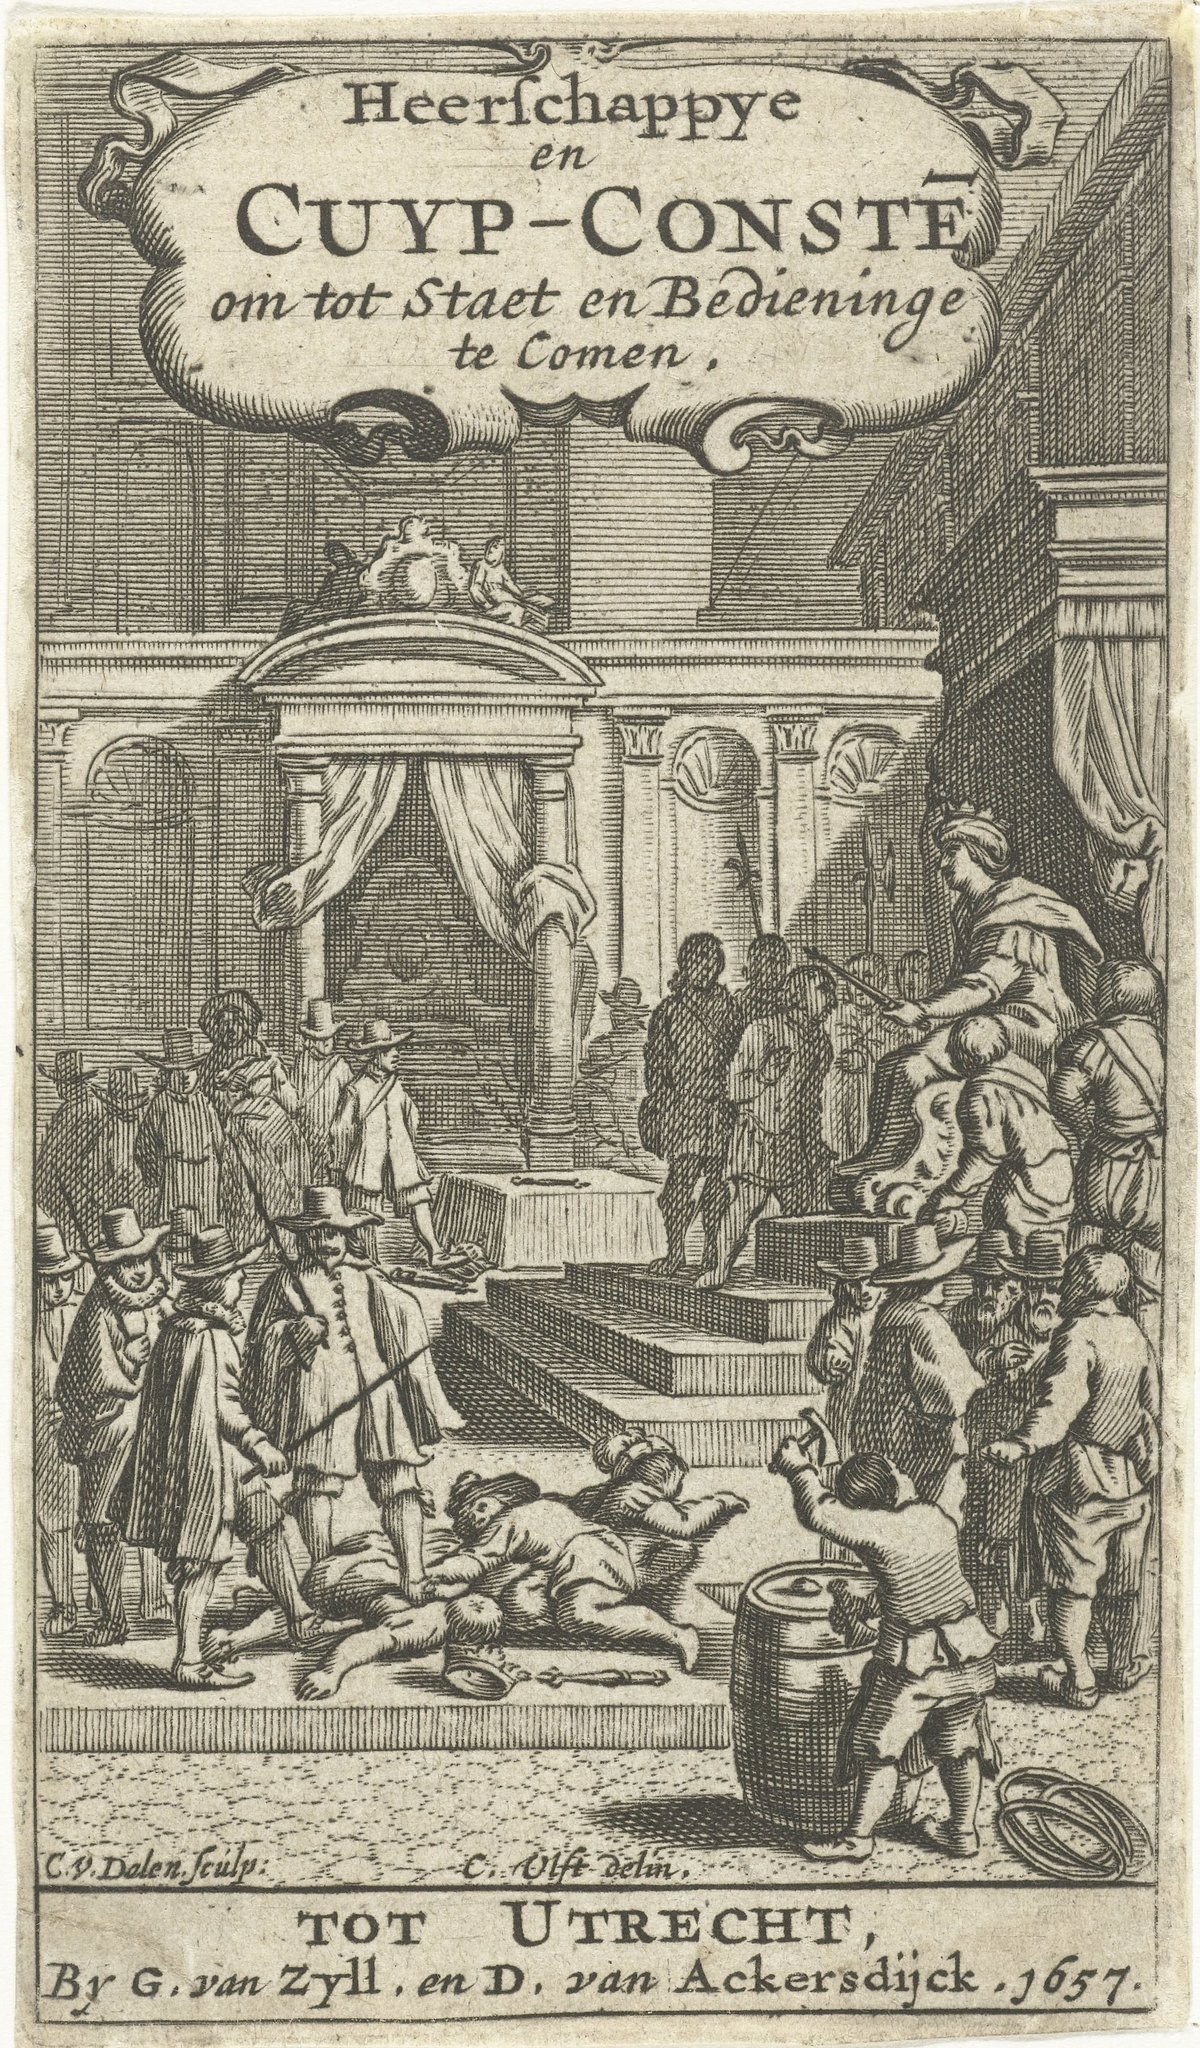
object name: print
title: Titelpagina voor: Bedekte konsten in regeringen en heerschappien, Utrecht 1657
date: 1657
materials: paper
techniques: engraving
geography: utrecht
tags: wooden container: barrel, cask, bucket, king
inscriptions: collector's mark: Lugt 2228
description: Titelpagina voor: Gerardus van Wassenaer, Bedekte konsten in regeringen en heerschappien, Utrecht, G. van Zijll and D. van Ackersdyck, 1657